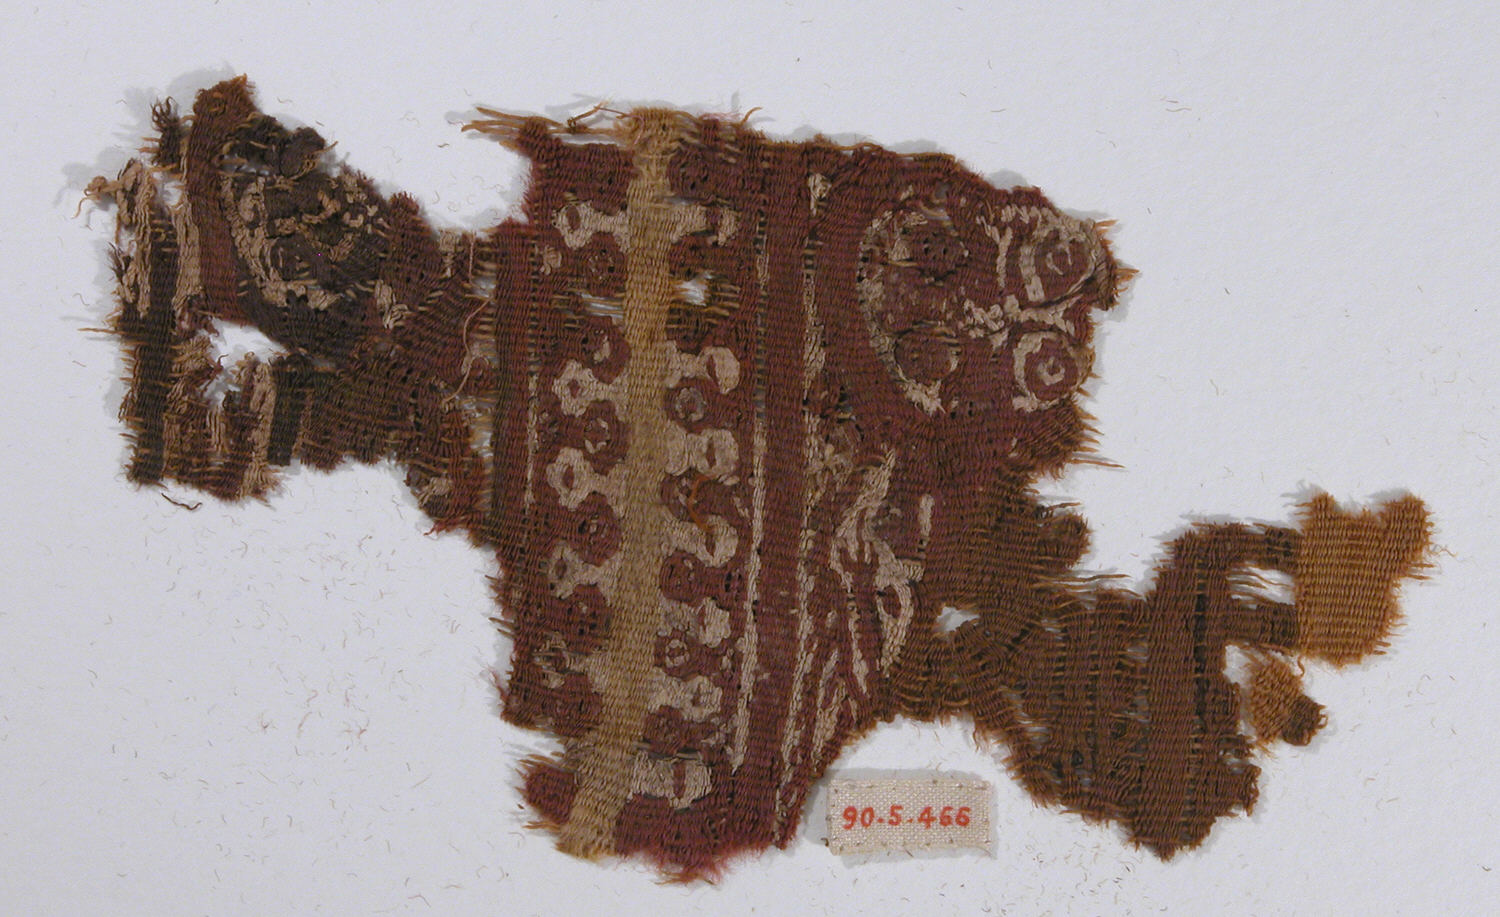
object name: textile fragment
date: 201-400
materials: linen, wool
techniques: weave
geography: egypt